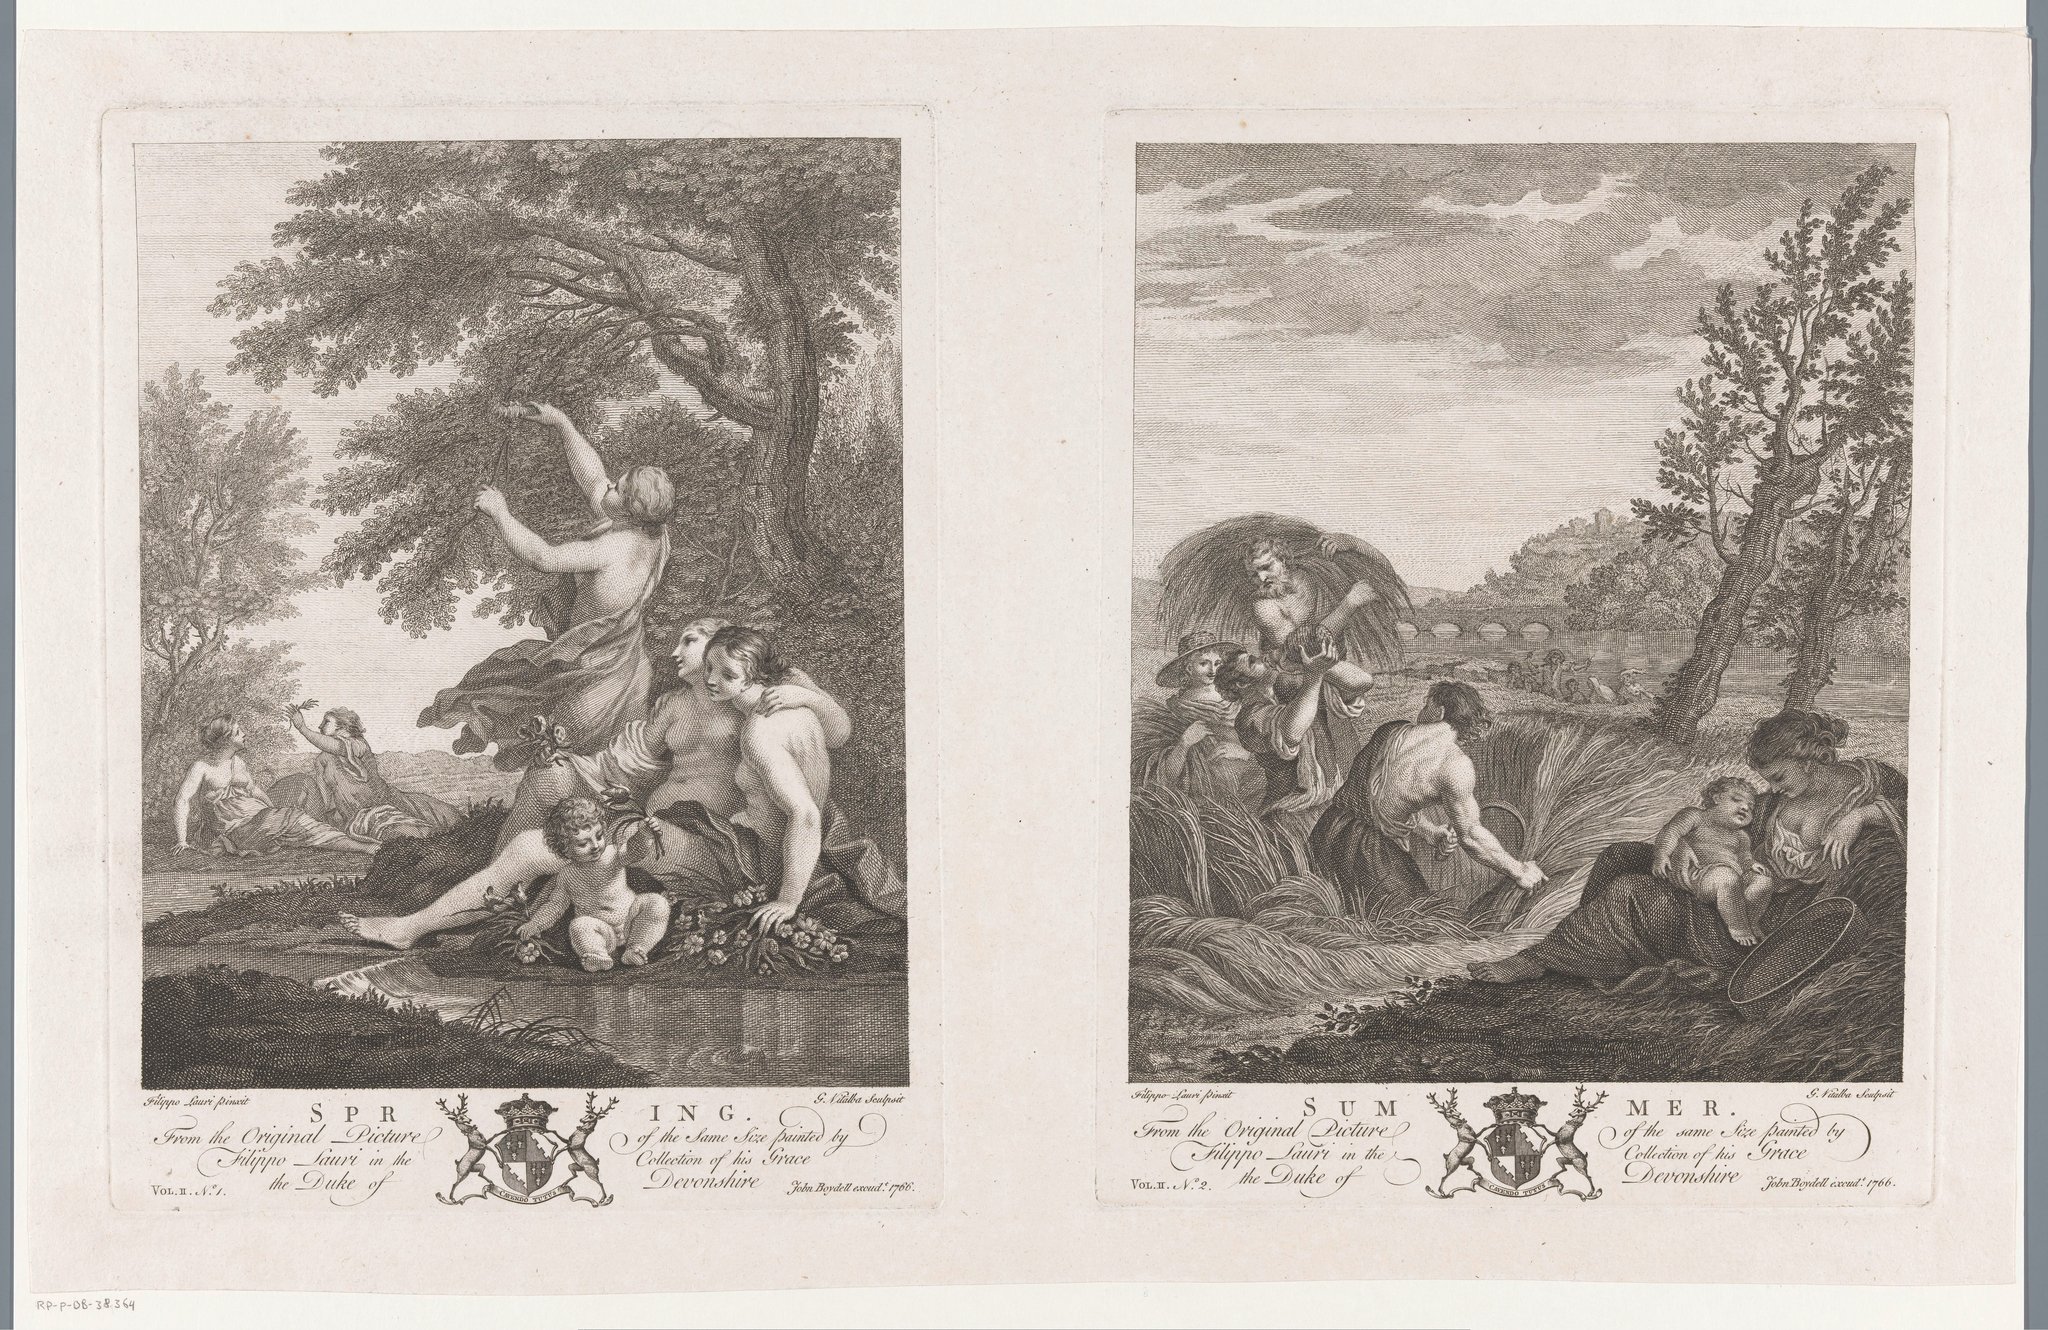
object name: print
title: Lente en zomer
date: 1766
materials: paper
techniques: engraving, etching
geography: england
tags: seasons of the year represented by scenes showing human activities, usually in a landscape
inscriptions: collector's mark: Lugt 2228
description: Links: figuren in een landschap in de lente. Tekst in het Engels in ondermarge. Genummerd linksonder: Vol. II. No. 1. Rechts: boeren aan het werk op het land in de zomer. Tekst in het Engels in ondermarge. Genummerd linksonder: Vol. II. No. 2.